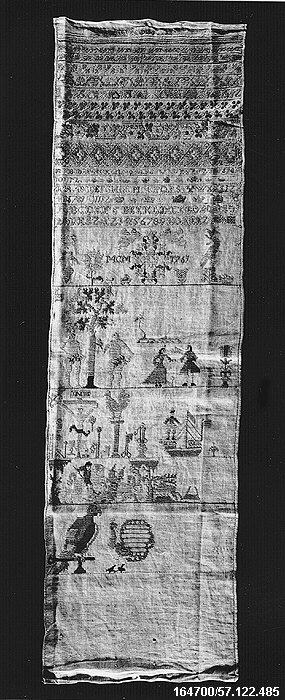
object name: sampler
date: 1761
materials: linen, silk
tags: birds,trees